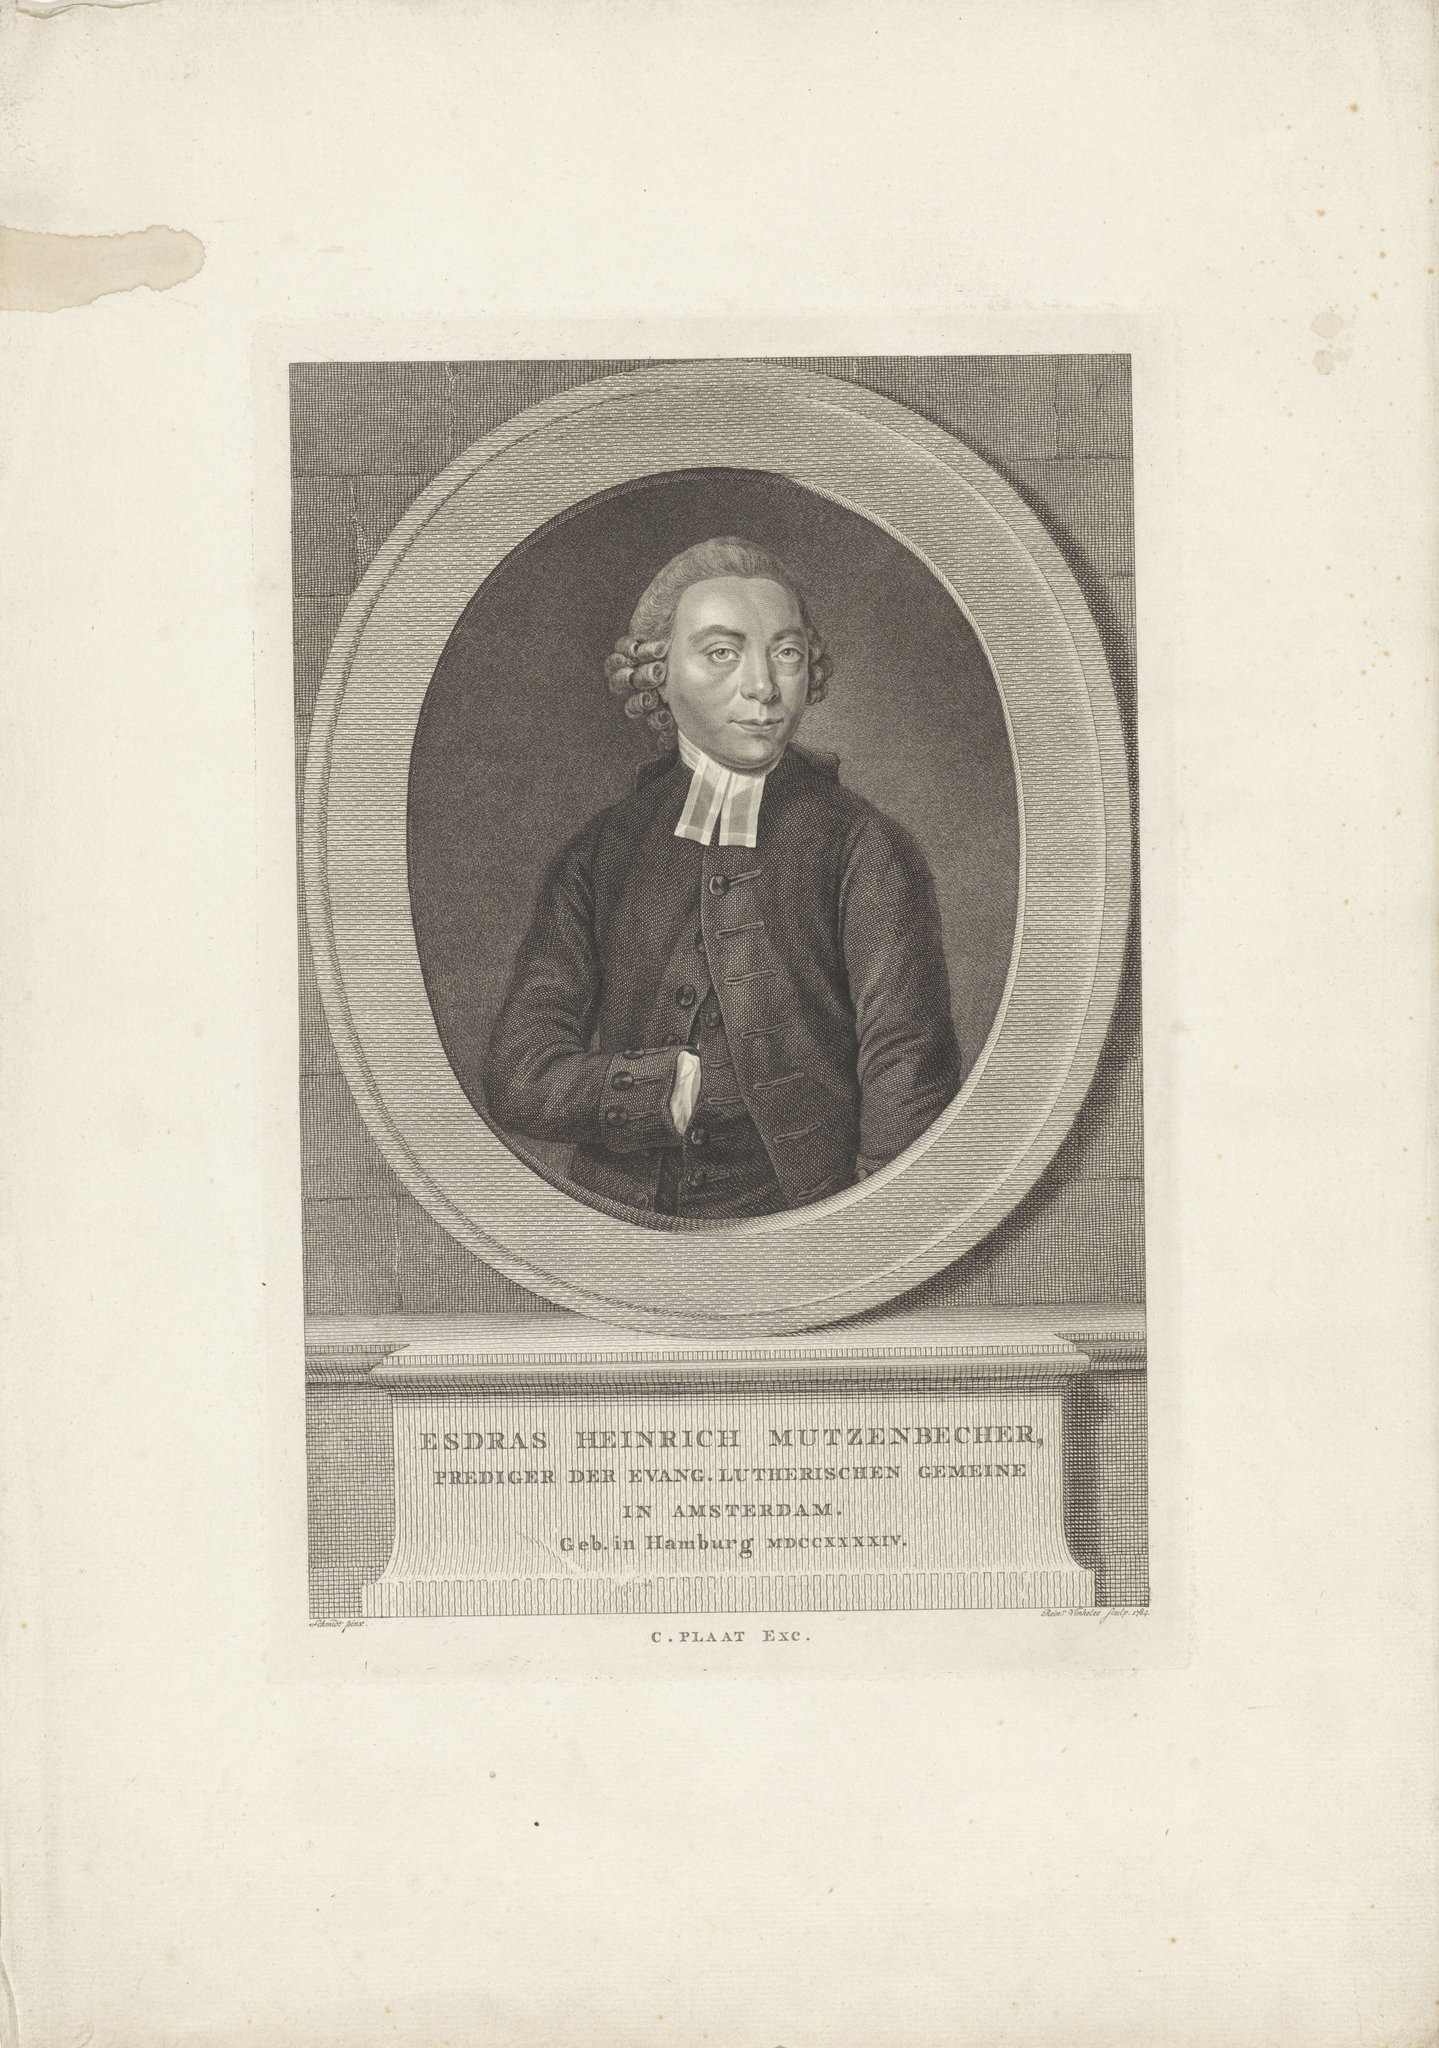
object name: print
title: Portret van de Amsterdamse predikant Esdras Heinrich Mützenbecher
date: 1784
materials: paper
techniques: engraving, etching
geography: the hague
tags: esdras heinrich mützenbecher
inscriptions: collector's mark: Lugt 2228